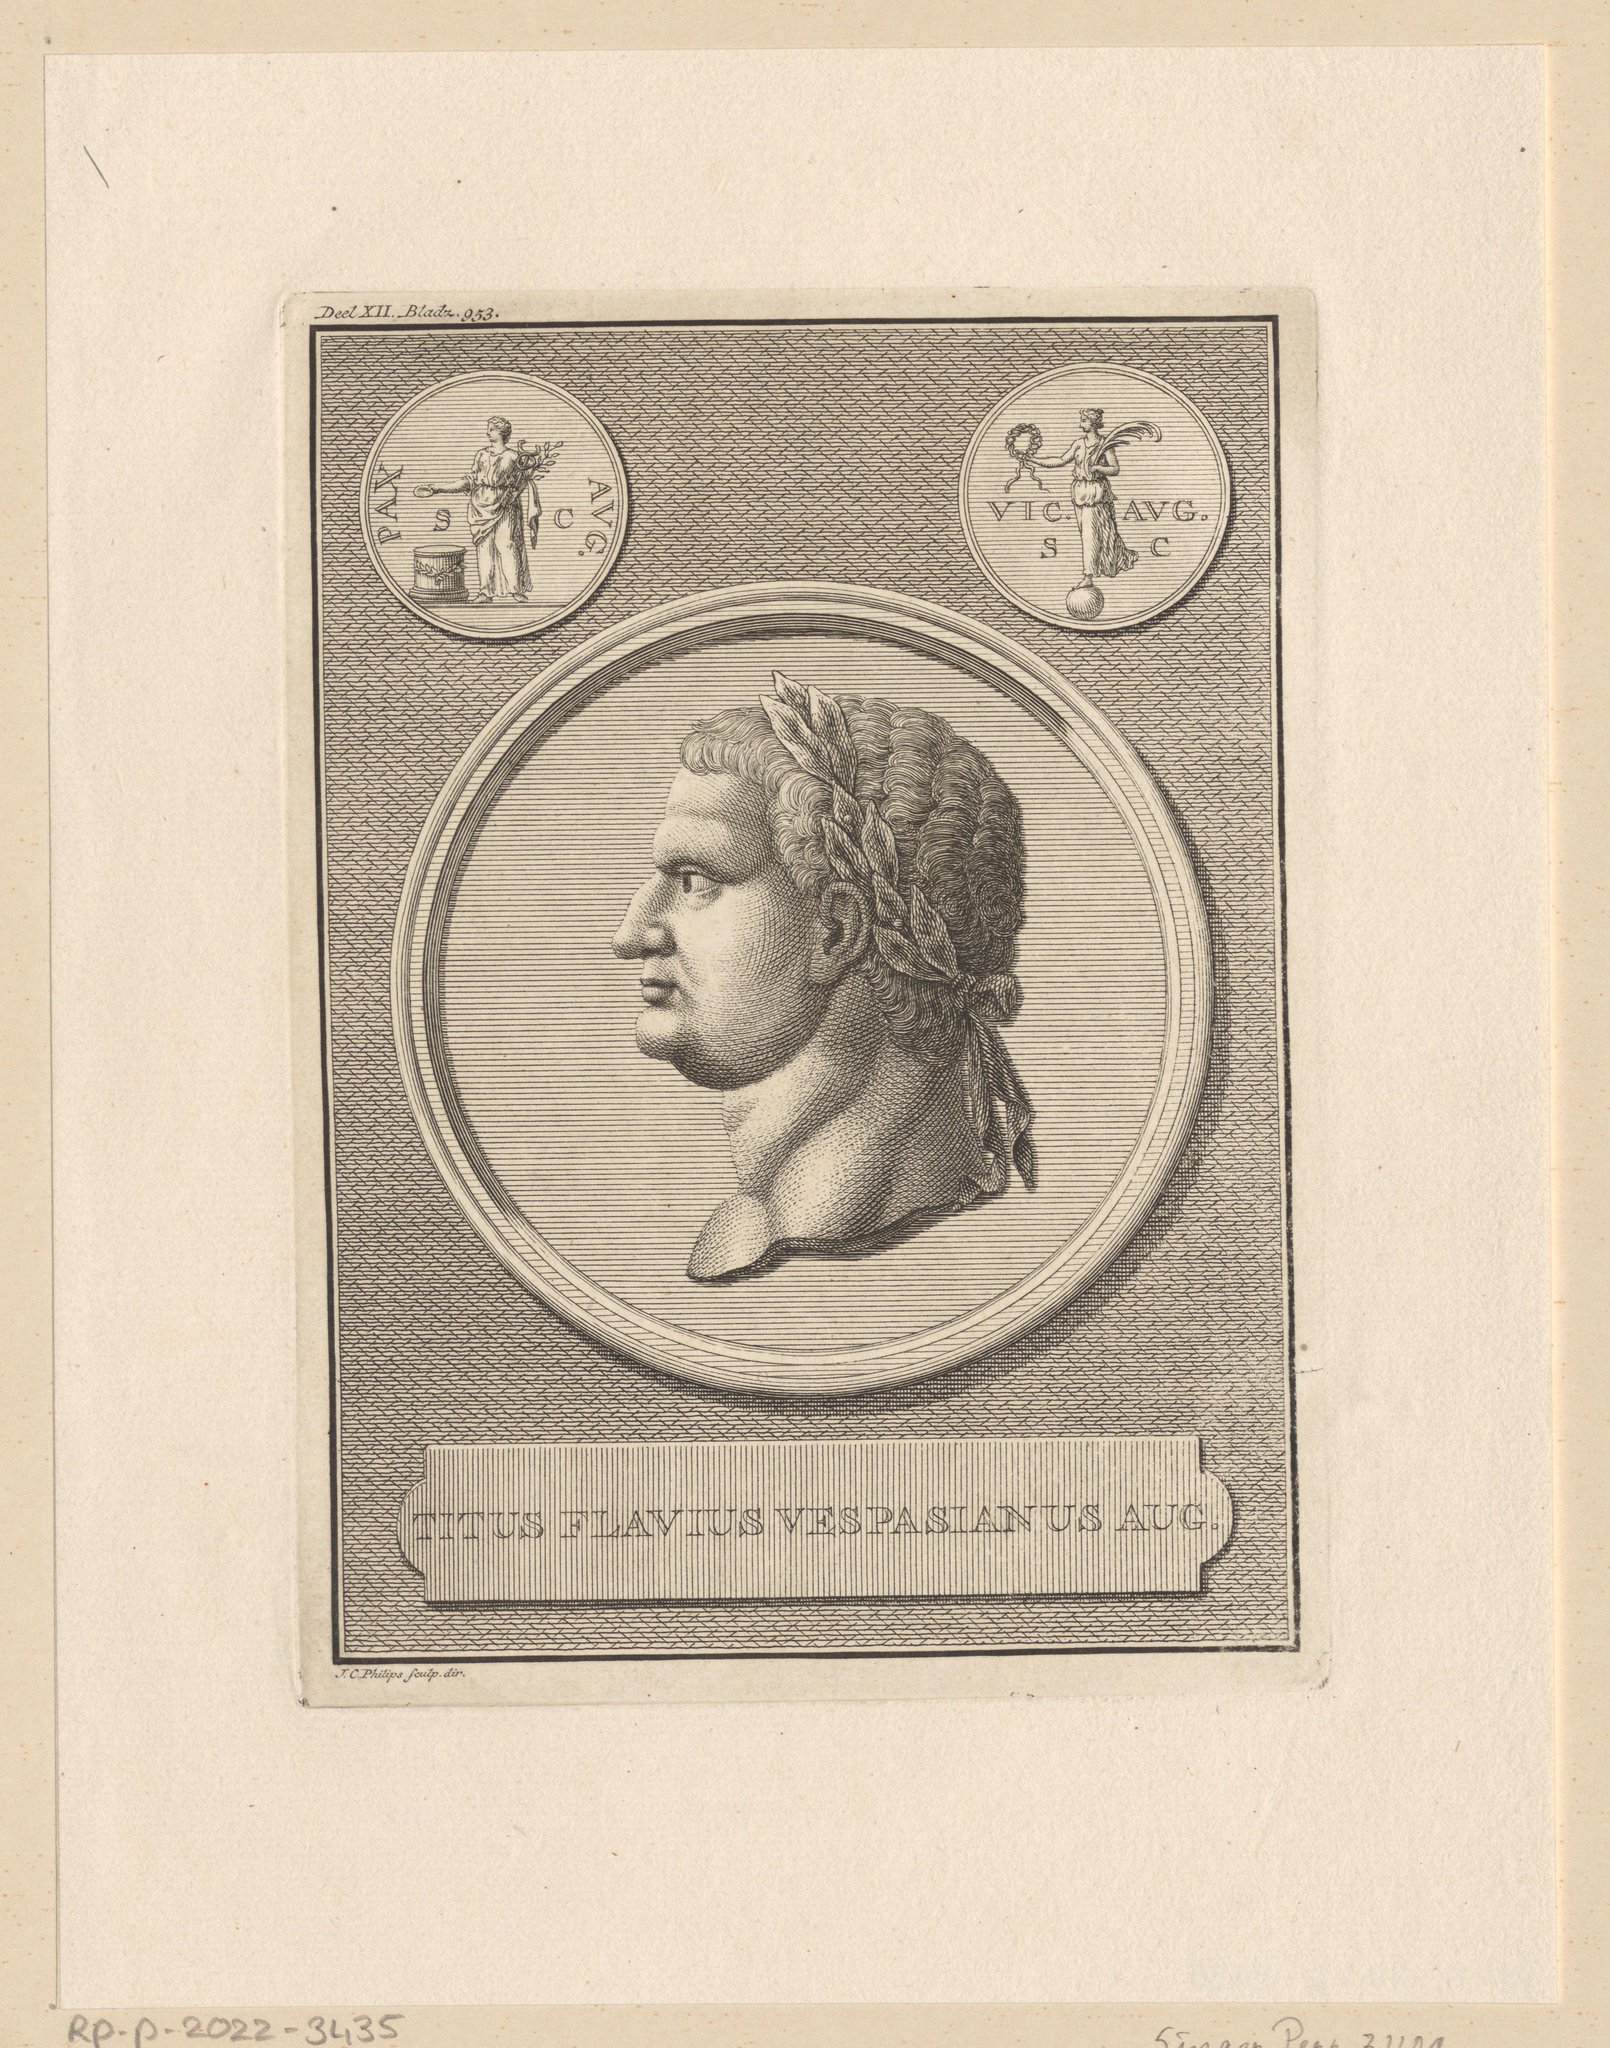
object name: print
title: Portret van keizer Titus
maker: jan caspar philips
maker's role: draughtsman, print maker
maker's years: 1700-1775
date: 1746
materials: paper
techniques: engraving, etching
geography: amsterdam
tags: (story of) the emperor titus - portrait of person from classical history, historical persons, emperor, coin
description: Prent waarschijnlijk uit: Westerbaen, Kornelis. Algemeene histori van het begin der wereld af tot den tegenwoordigen tijd toe. Utrecht: Herman Besseling, 1746. dl. 12.